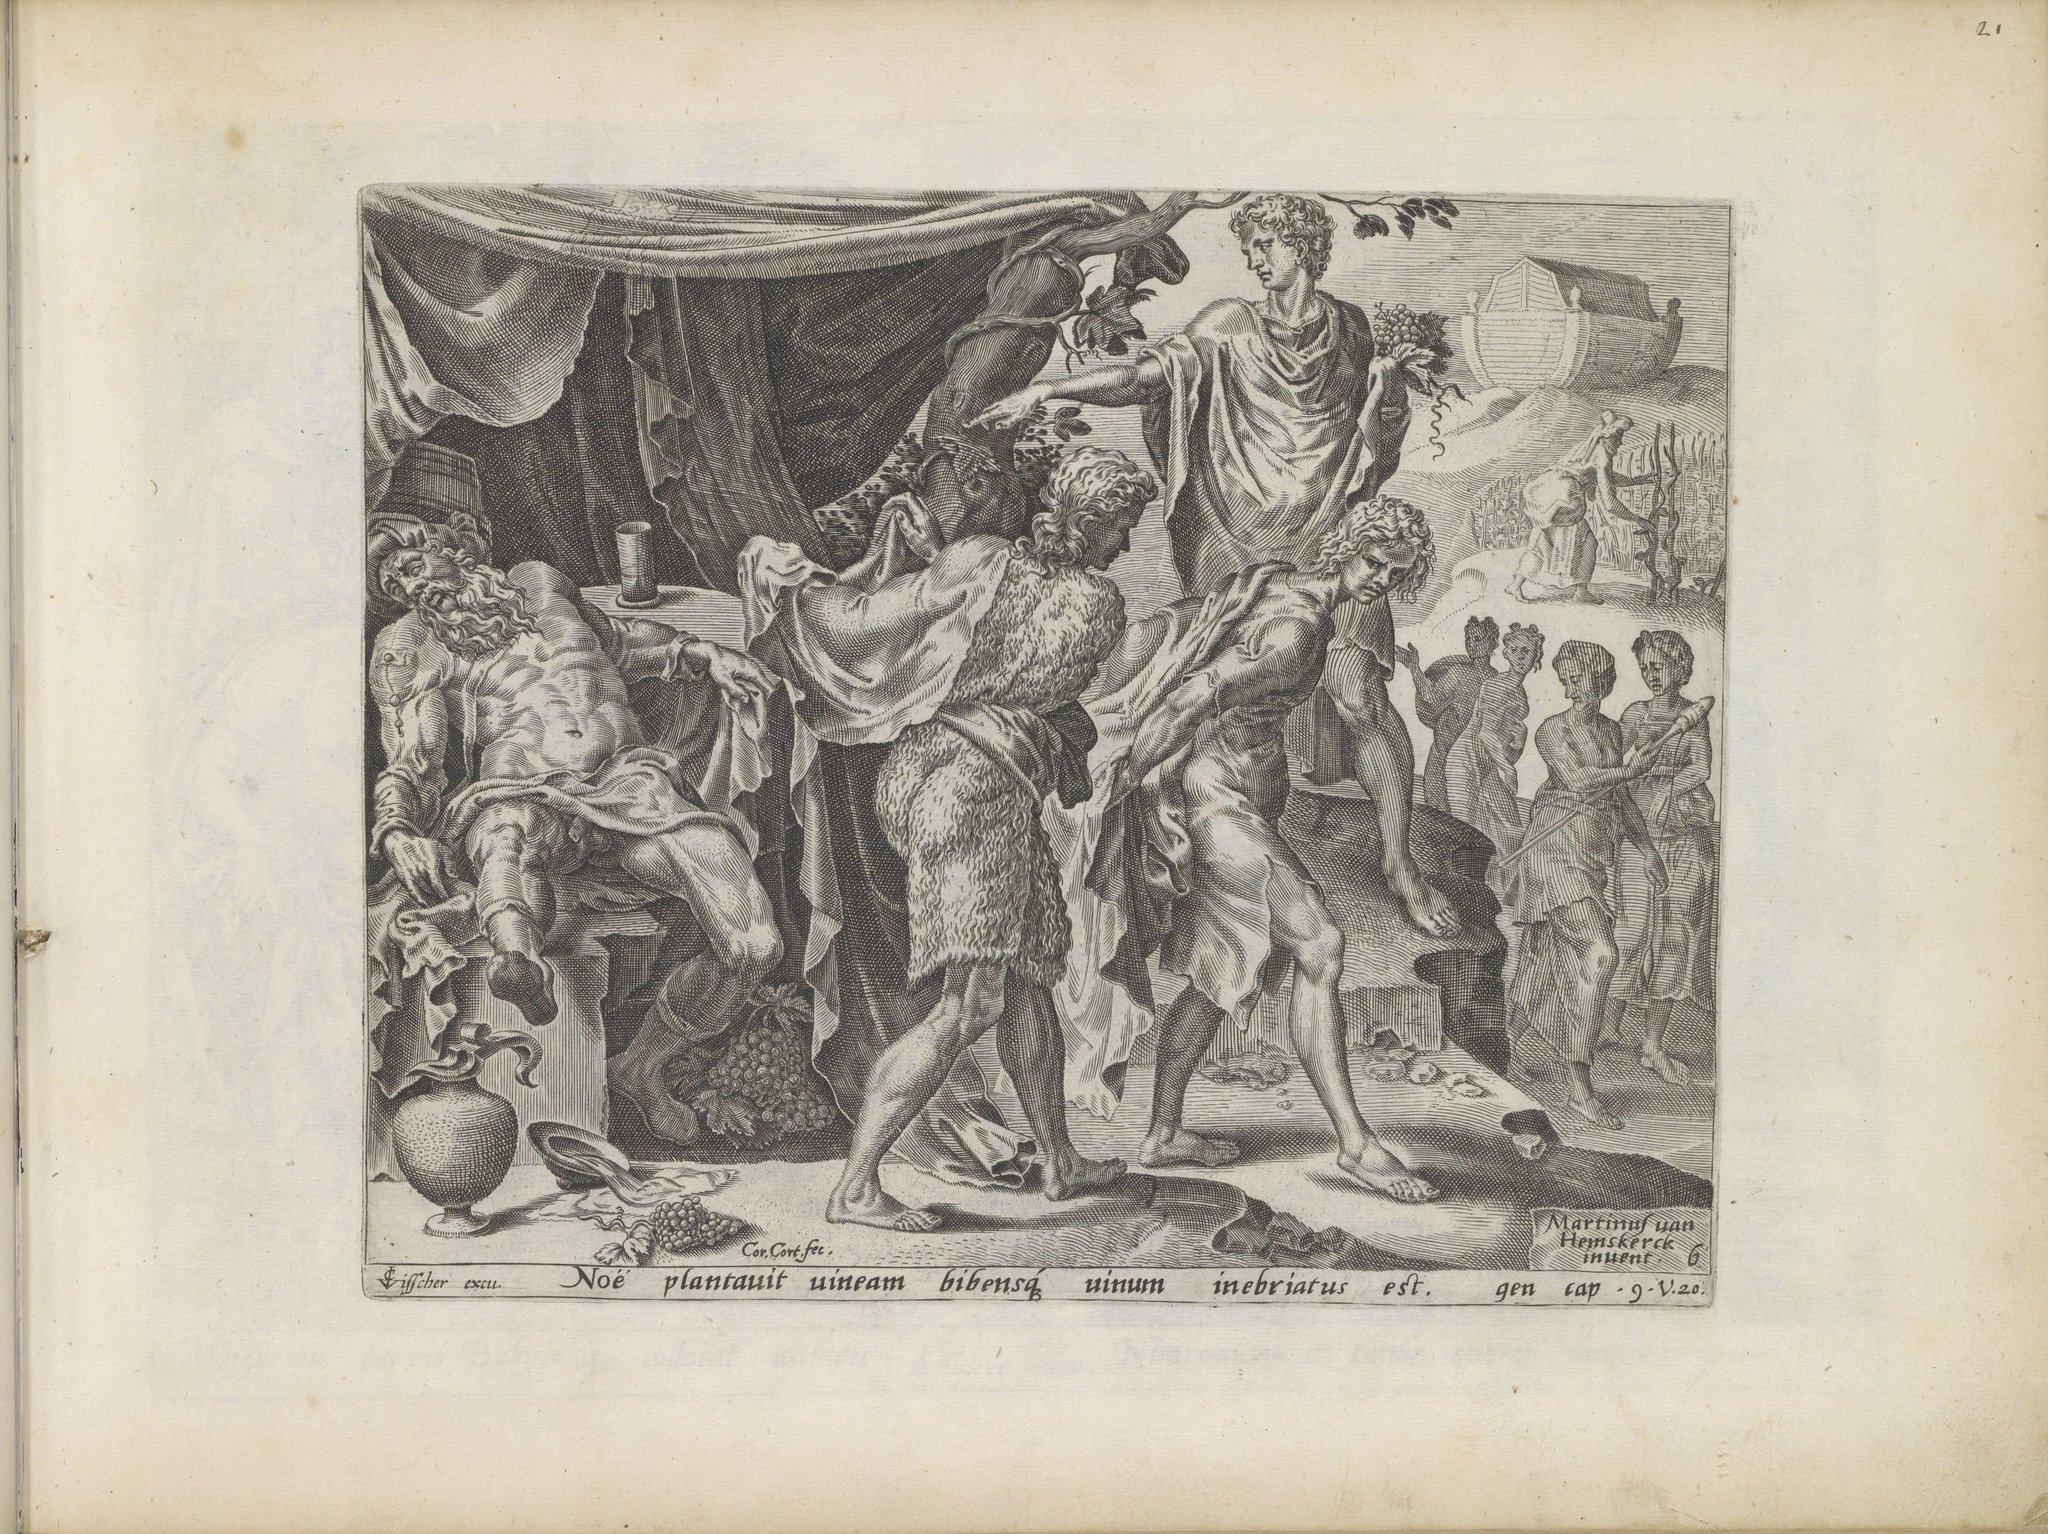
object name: print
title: Theatrum Biblicum Hoc Est Historiae Sacrae Veteris et Novi Testamenti Tabulis Aeneis Expressae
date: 1558-1560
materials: paper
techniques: engraving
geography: amsterdam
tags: shem and japheth walking backwards towards noah, the mocking of noah: ham finds his father (partially) naked sleeping out of doors (or in his tent, or in the vineyard cottage); ham calls his brothers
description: Noach ligt dronken en half ontkleed in zijn tent. Op de grond een wijnkruik en op de tafel naast hem een wijnbeker. Zijn zoon Cham wijst naar hem en bespot hem. Sem en Jafet schermen hun vader af met een kleed. Rechts achter is Noach te zien hoe hij zijn wijngaard bewerkt, op een heuvel staat de ark. Onderaan een verwijzing naar de Bijbeltekst in Gen. 9:20 in het Latijn. Deze prent maakt deel uit van een album.